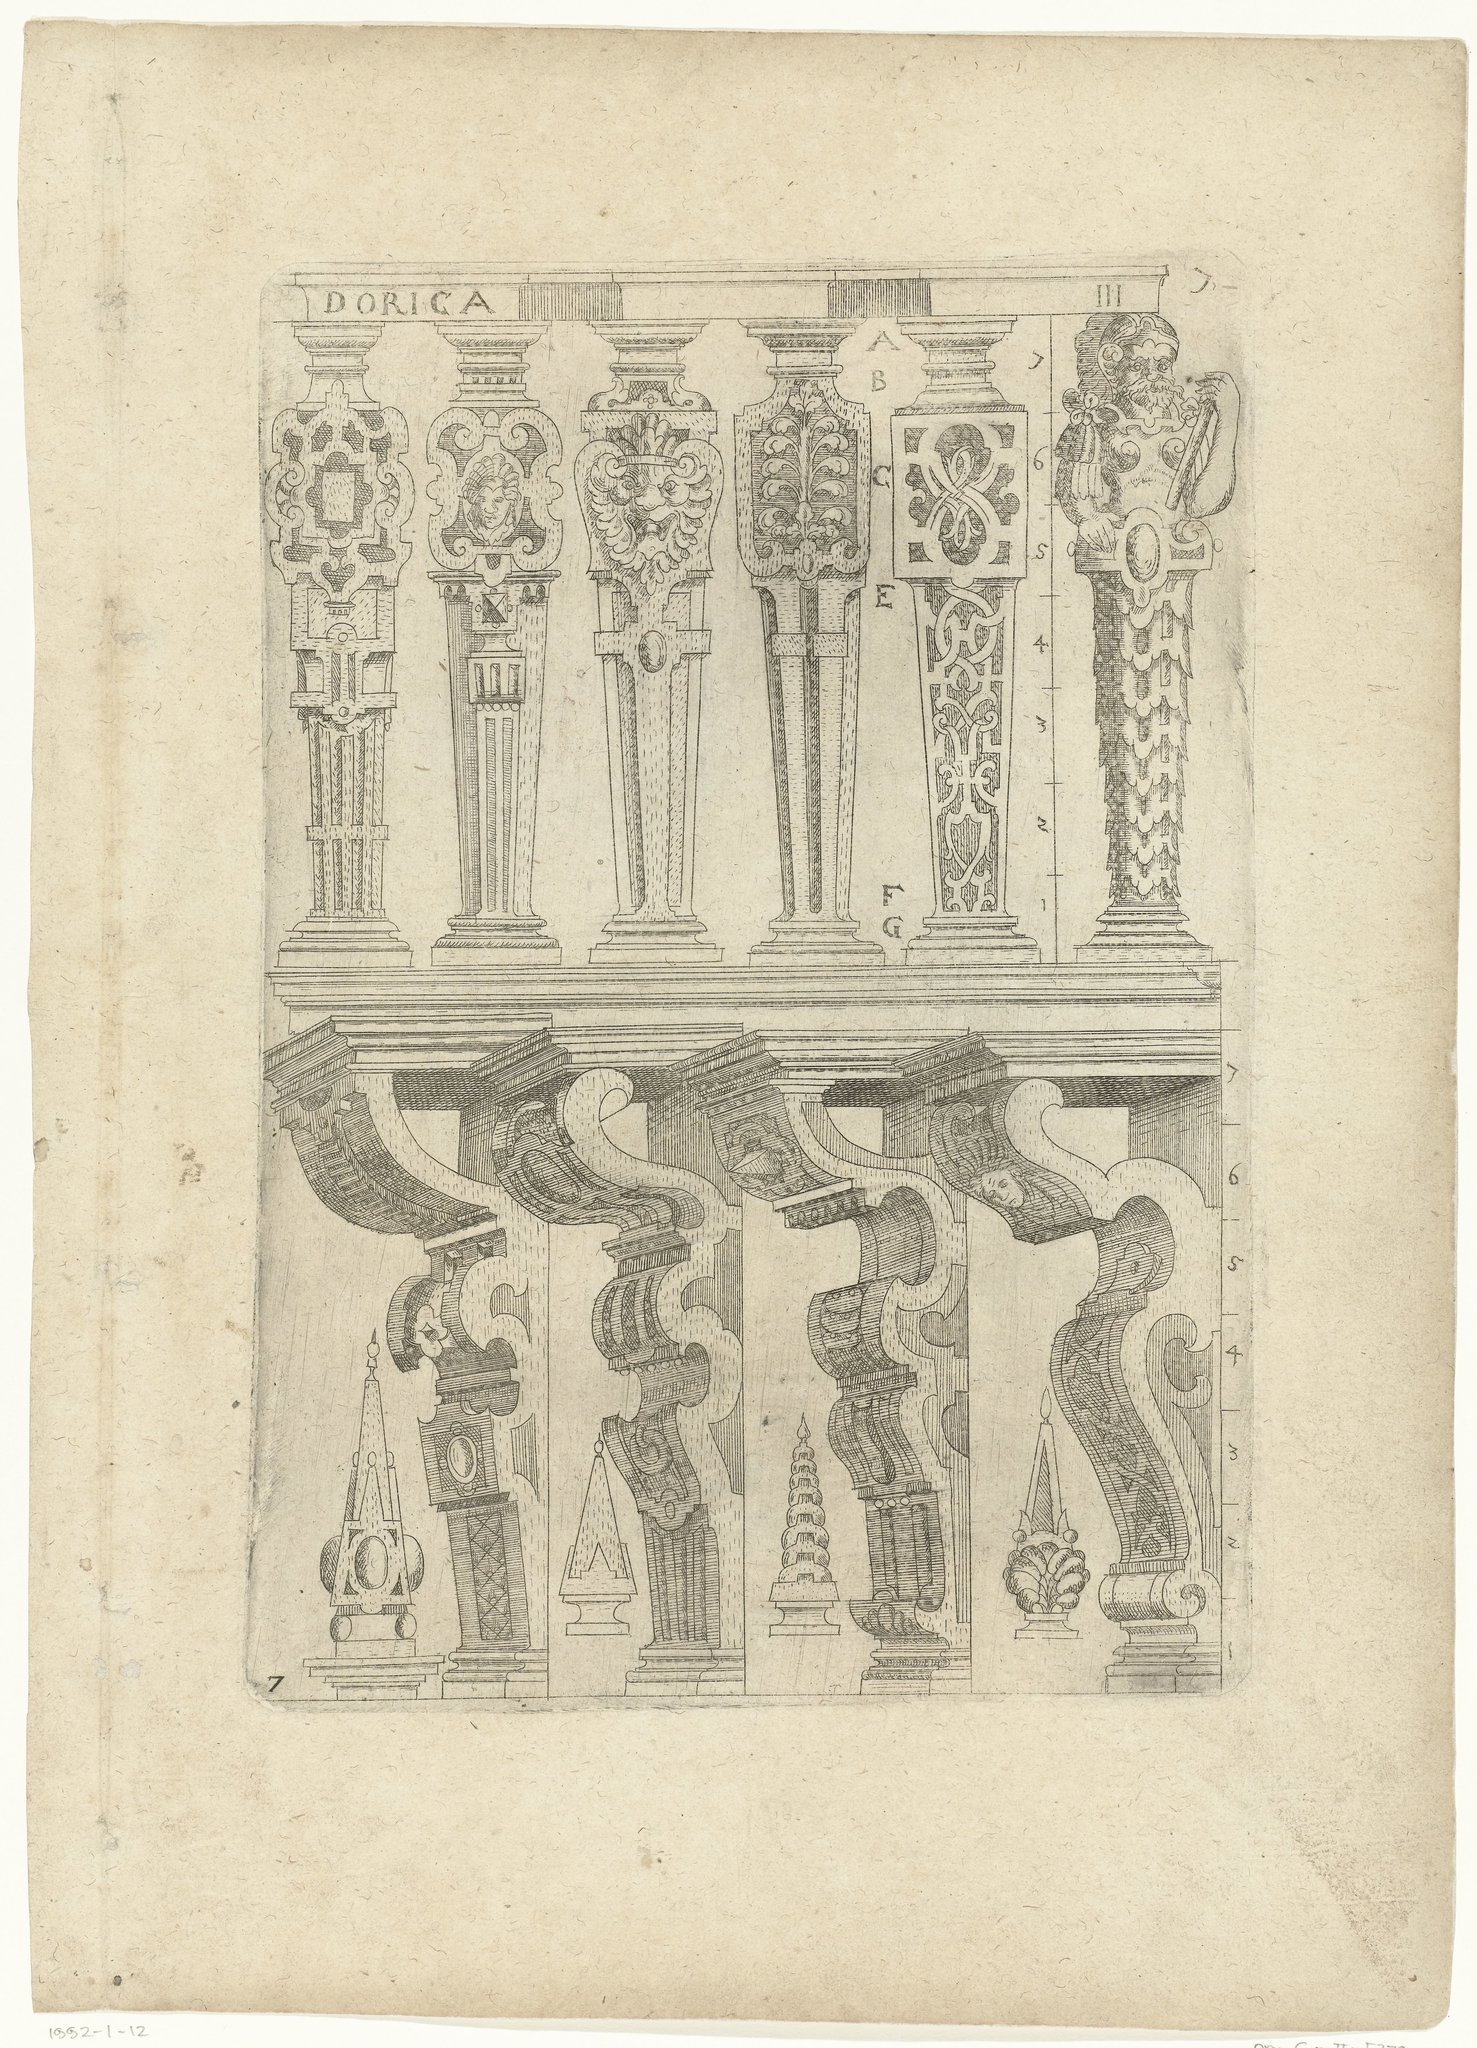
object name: print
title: Zes balusters of termen van voren en vier termen van opzij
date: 1610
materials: paper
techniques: etching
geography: cologne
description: Bovenaan zijn balusters of termen van voren te zien, rechts staat een maarschalk met een baton. Onderaan zijn termen met daarnaast pinakels afgebeeld. Blad 7 uit serie van titelblad en 28 bladen.